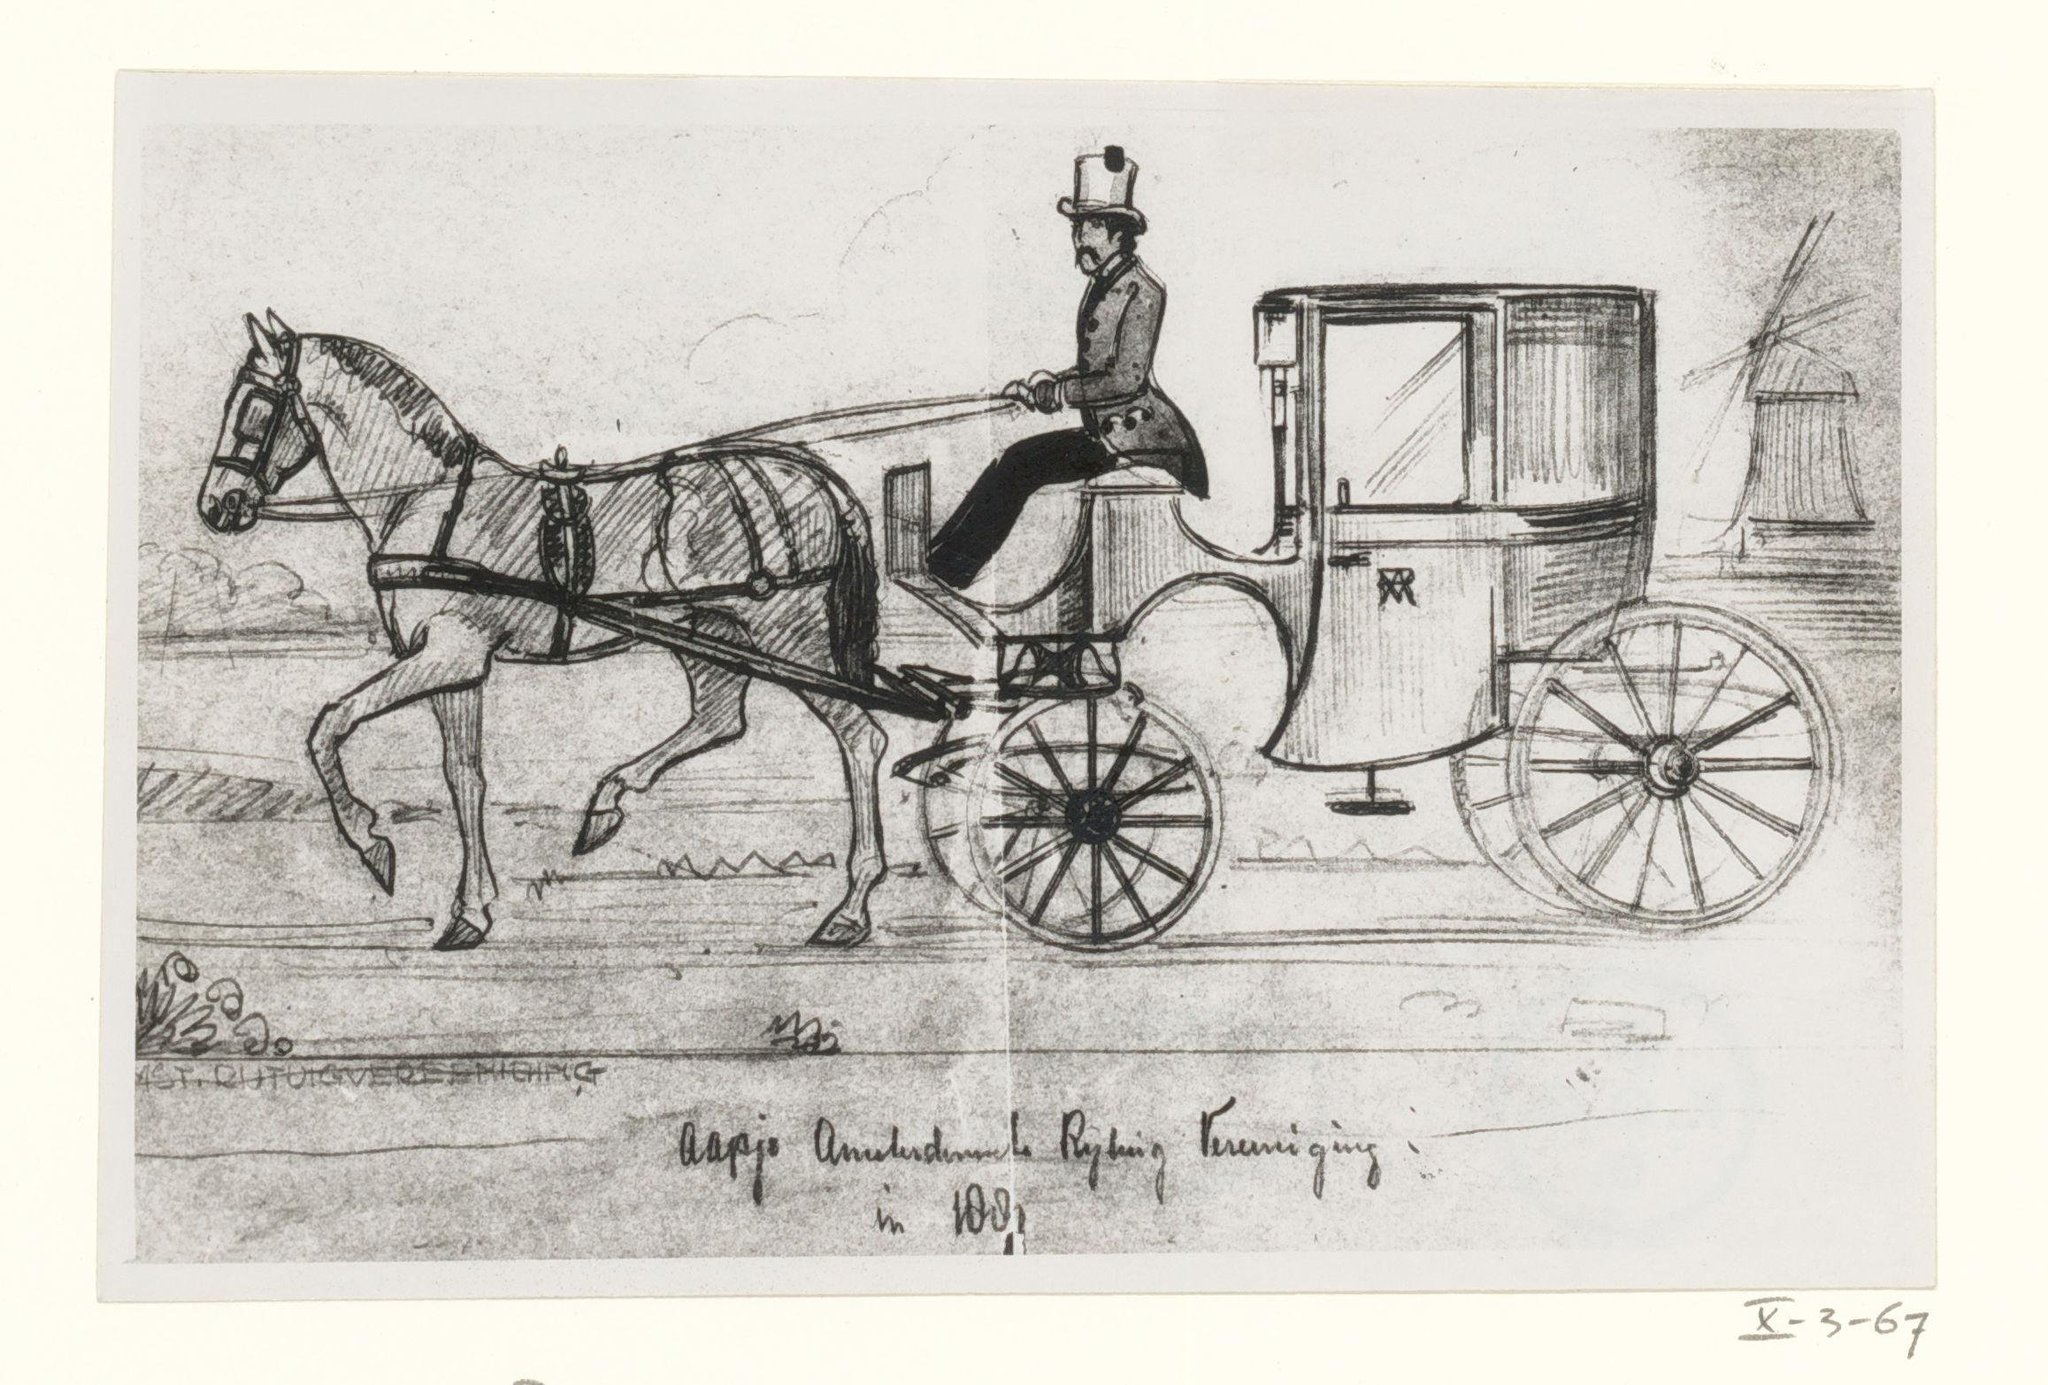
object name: photograph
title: Reproductie van Aapje Amsterdamsche Rijtuig Vereeniging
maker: Anonymous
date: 1900-1949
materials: paper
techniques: gelatin silver print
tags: four-wheeled vehicle drawn by one animal, windmill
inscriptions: stamp, collector's mark: Lugt 1641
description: Reproductie van een tekening van het Aapje, een Amsterdam huurrijtuig uit 1881. Waarschijnlijk is de benaming Aapje ontstaan in 1880 toen de Amsterdamsche Rijtuig Maatschappij werd ingericht en de koetsiers een opvallend uniform kregen: een bruine rijrok, een rood vest, een zwartgelakte hoge hoed en een zwarte regenjas. Onderwerpsrubrieken binnen de Atlas Zeden en Gewoonten: Handel, nijverheid en verkeer, Vervoermiddelen te land en te water, vervoermiddelen te land, Rijtuigen en Statiekarossen.